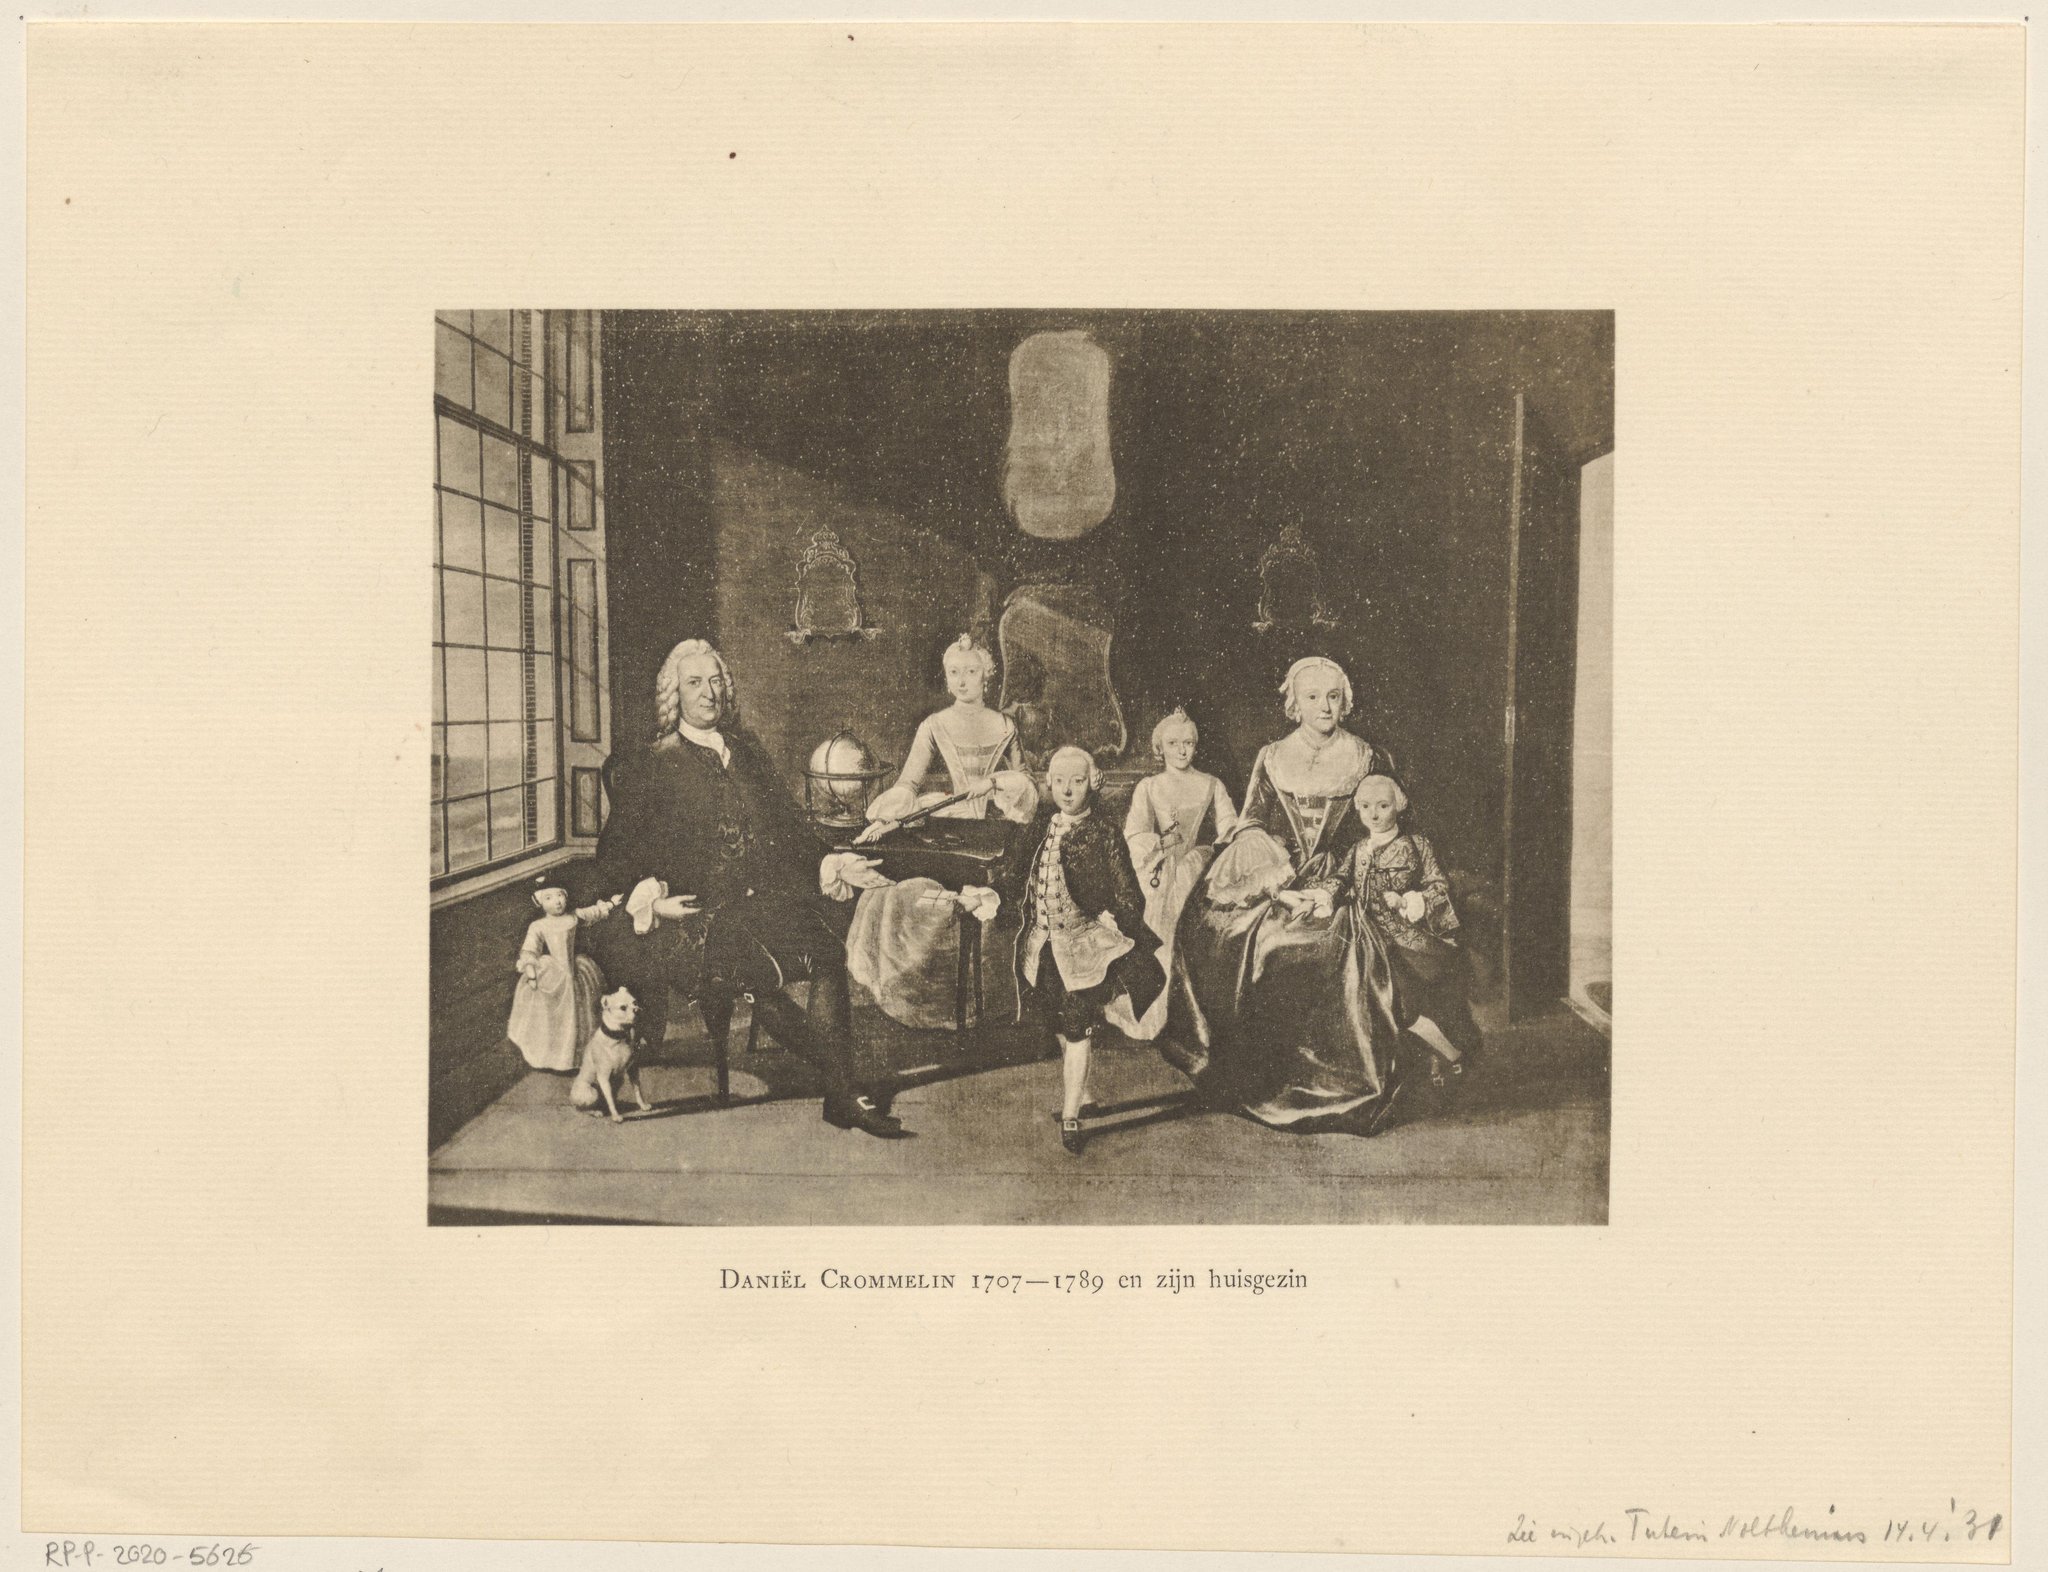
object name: photomechanical print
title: Familieportret van Daniel Crommelin, Marie le Plastrier, Robert Daniel Crommelin I, Gulian Crommelin, Marianne Aimee Crommelin, Susanne Crommelin en Judith Crommelin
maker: Anonymous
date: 1900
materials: paper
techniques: photograph, letterpress printing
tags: leiden, amsterdam, historical persons - bb - woman, historical persons